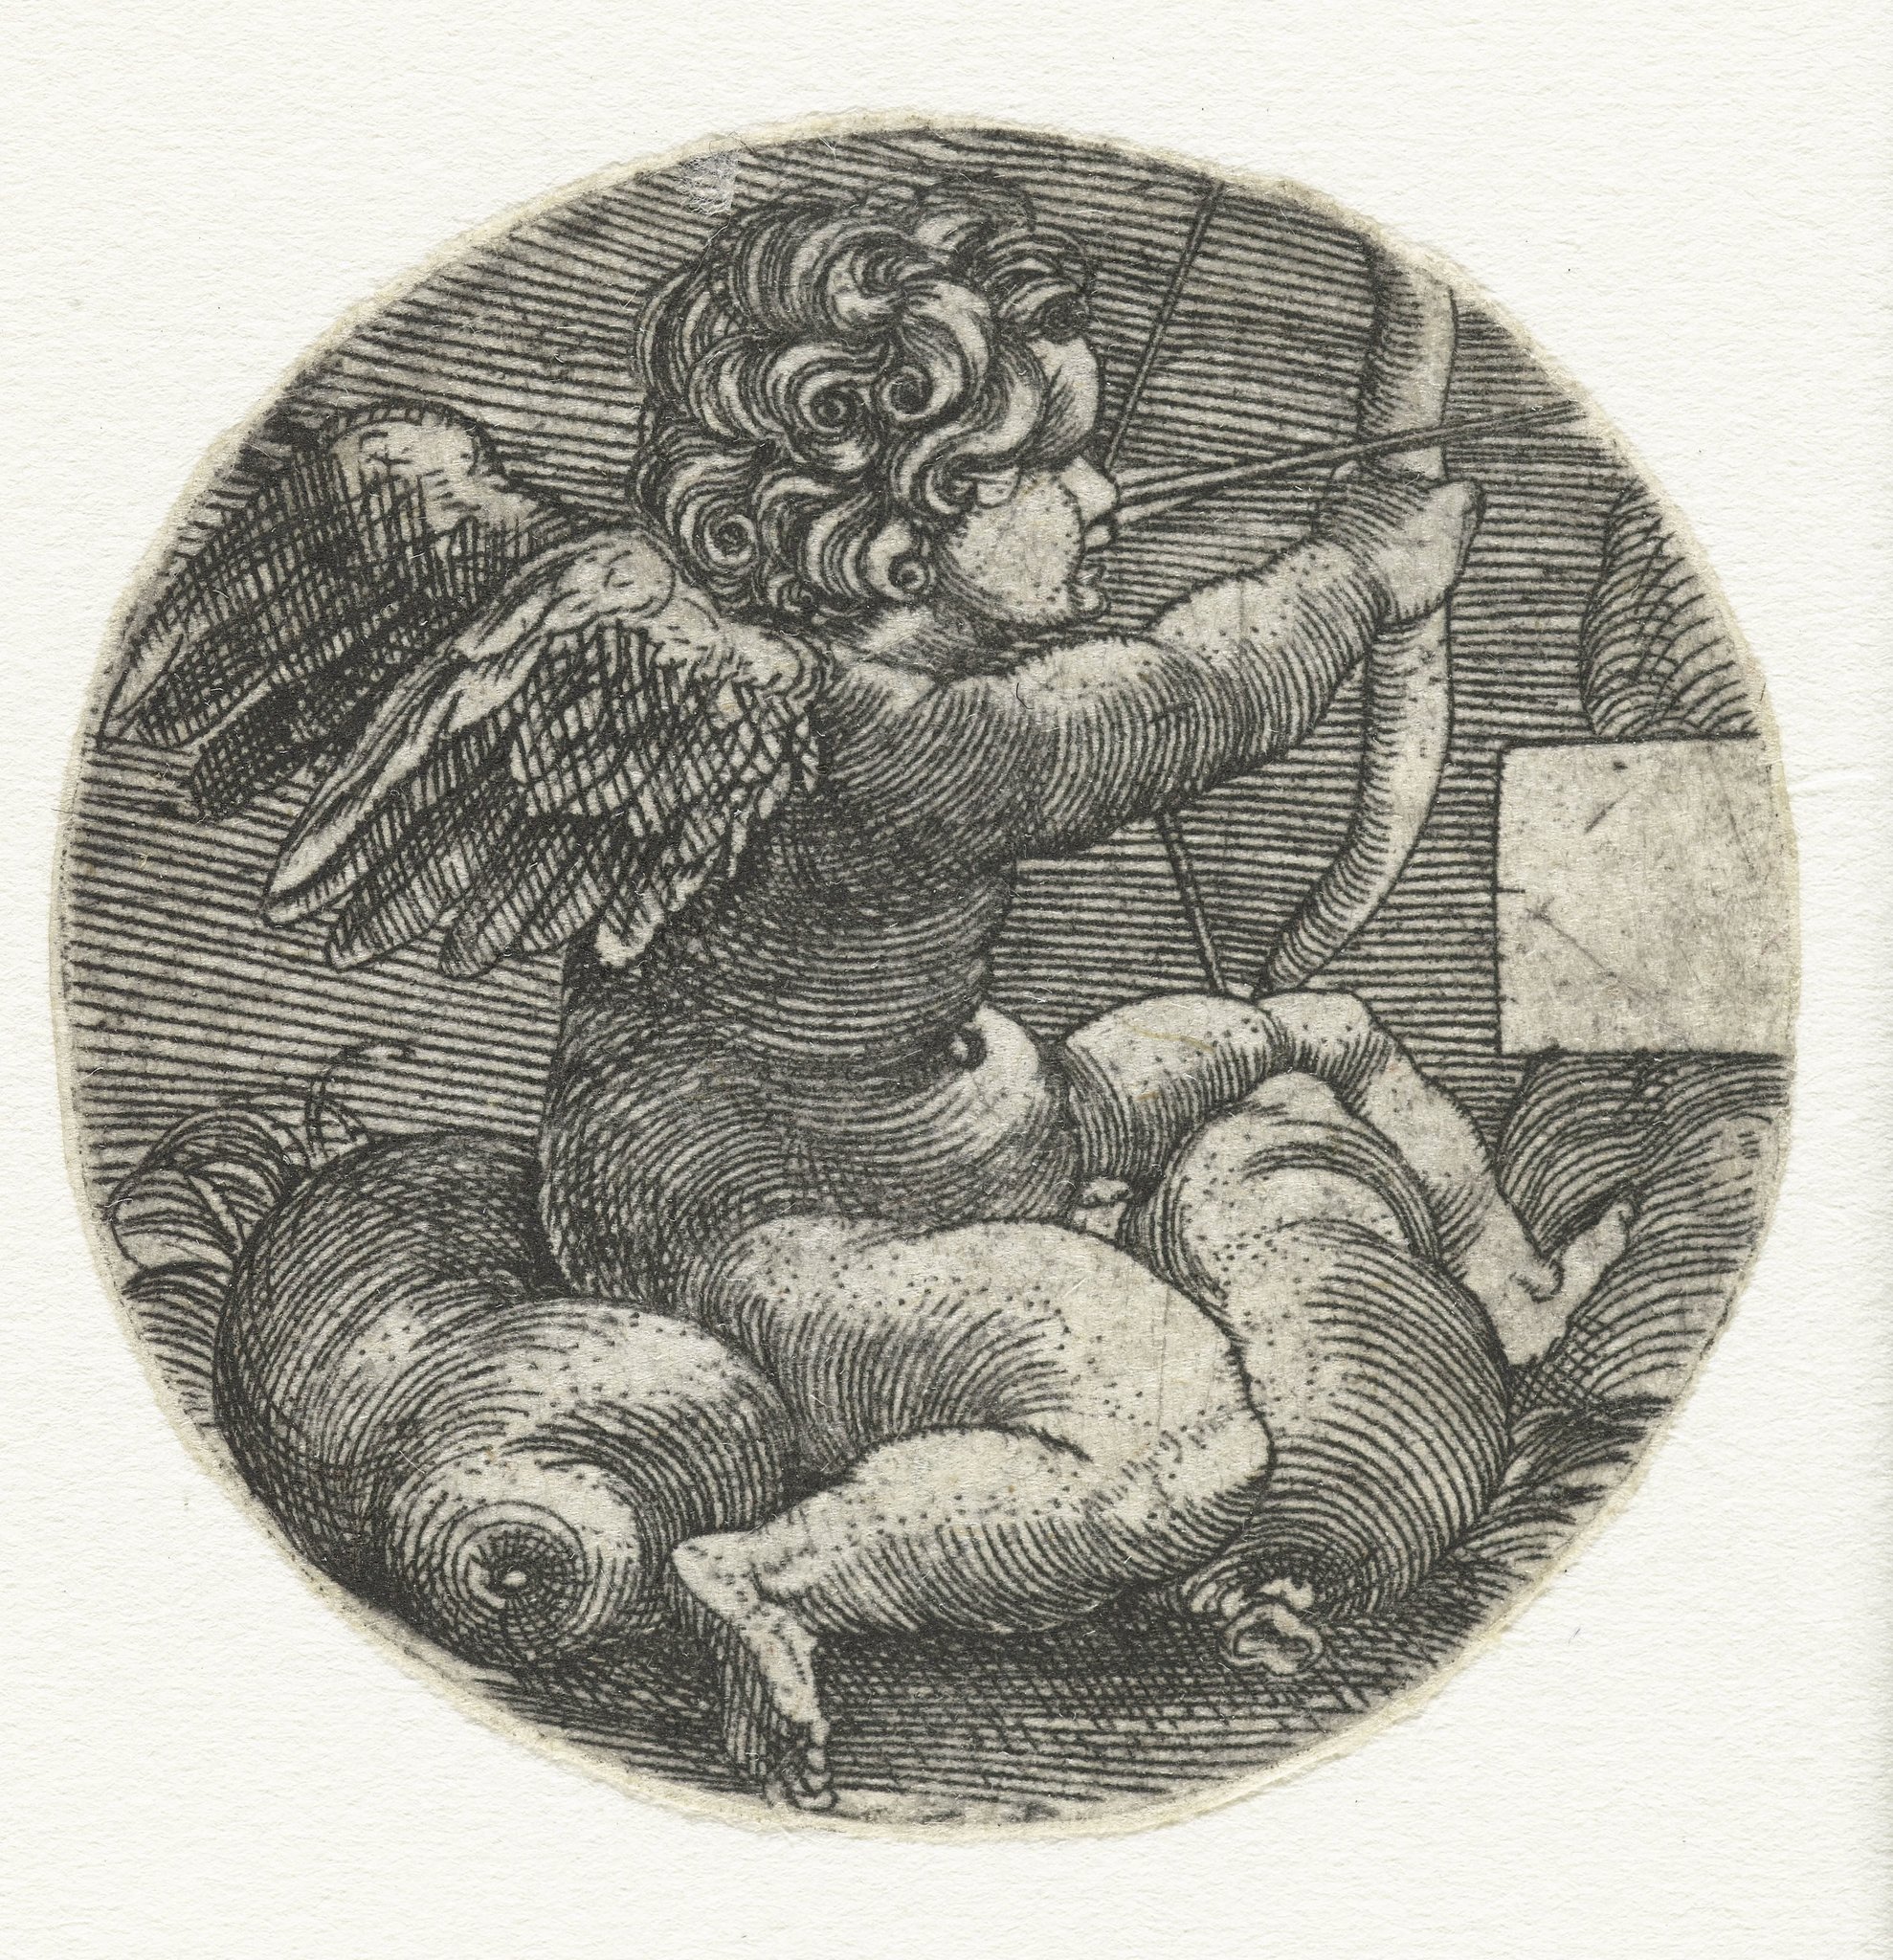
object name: print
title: Cupido met pijl en boog gezeten op een kussen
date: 1512-1599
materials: paper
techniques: engraving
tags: (story of) cupid, amor (eros)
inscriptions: collector's mark: Lugt 2228a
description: Kopie naar een prent van Agostino Veneziano